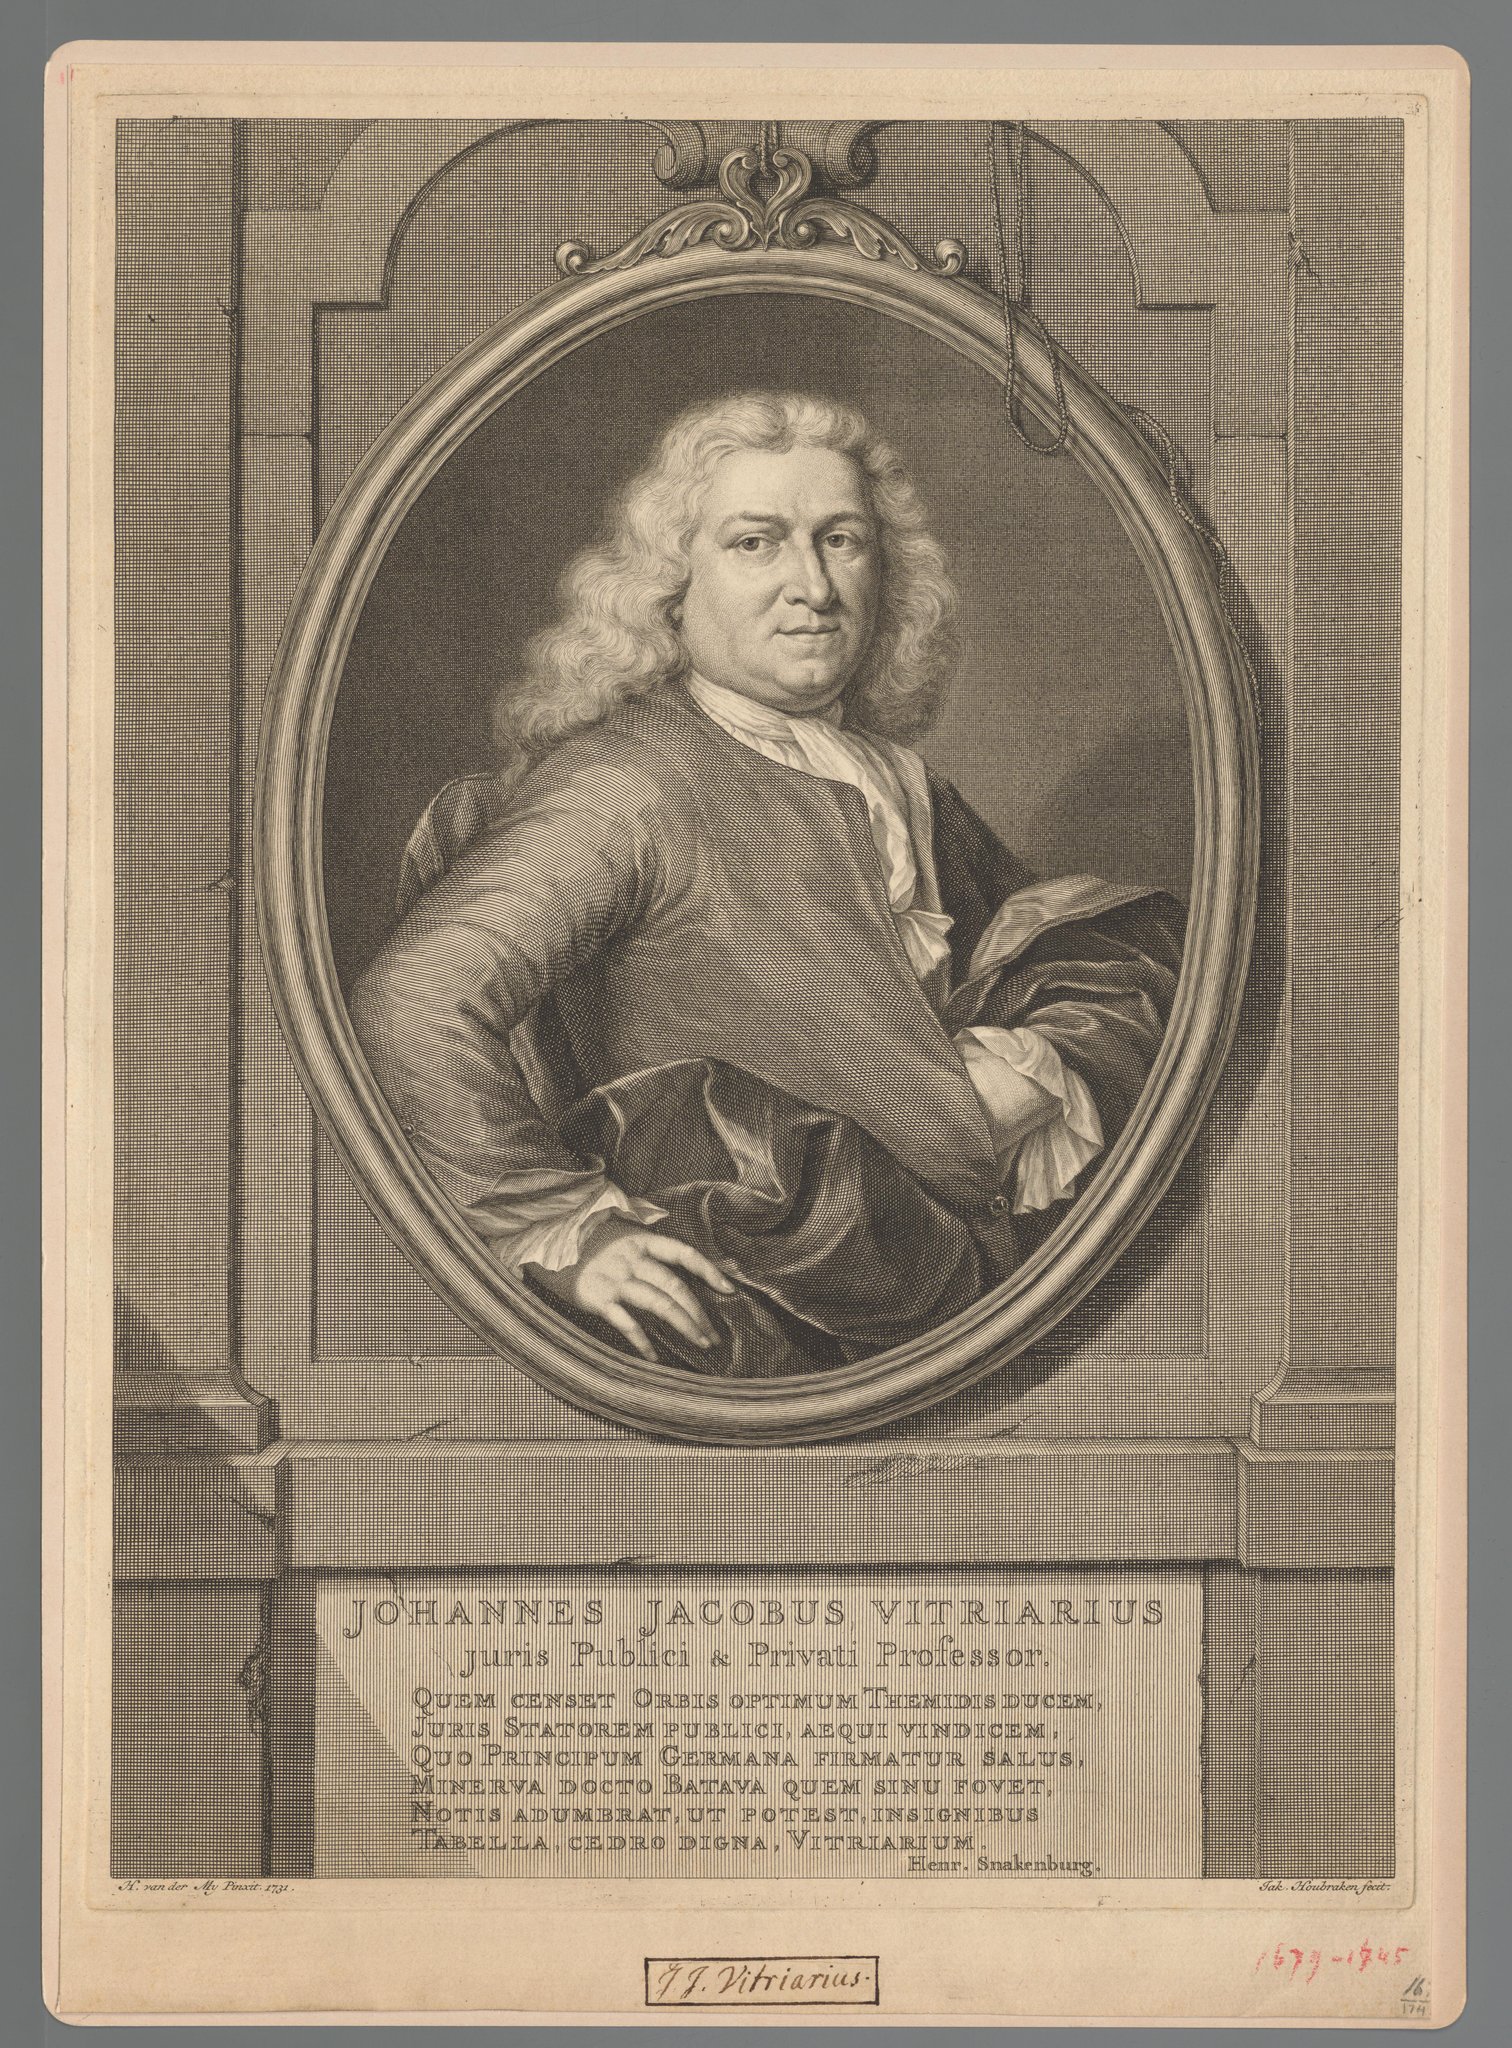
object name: print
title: Portret van Johannes Jacobus Vitriarius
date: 1731-1780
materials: paper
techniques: engraving, etching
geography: amsterdam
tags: scholar, philosopher, historical persons